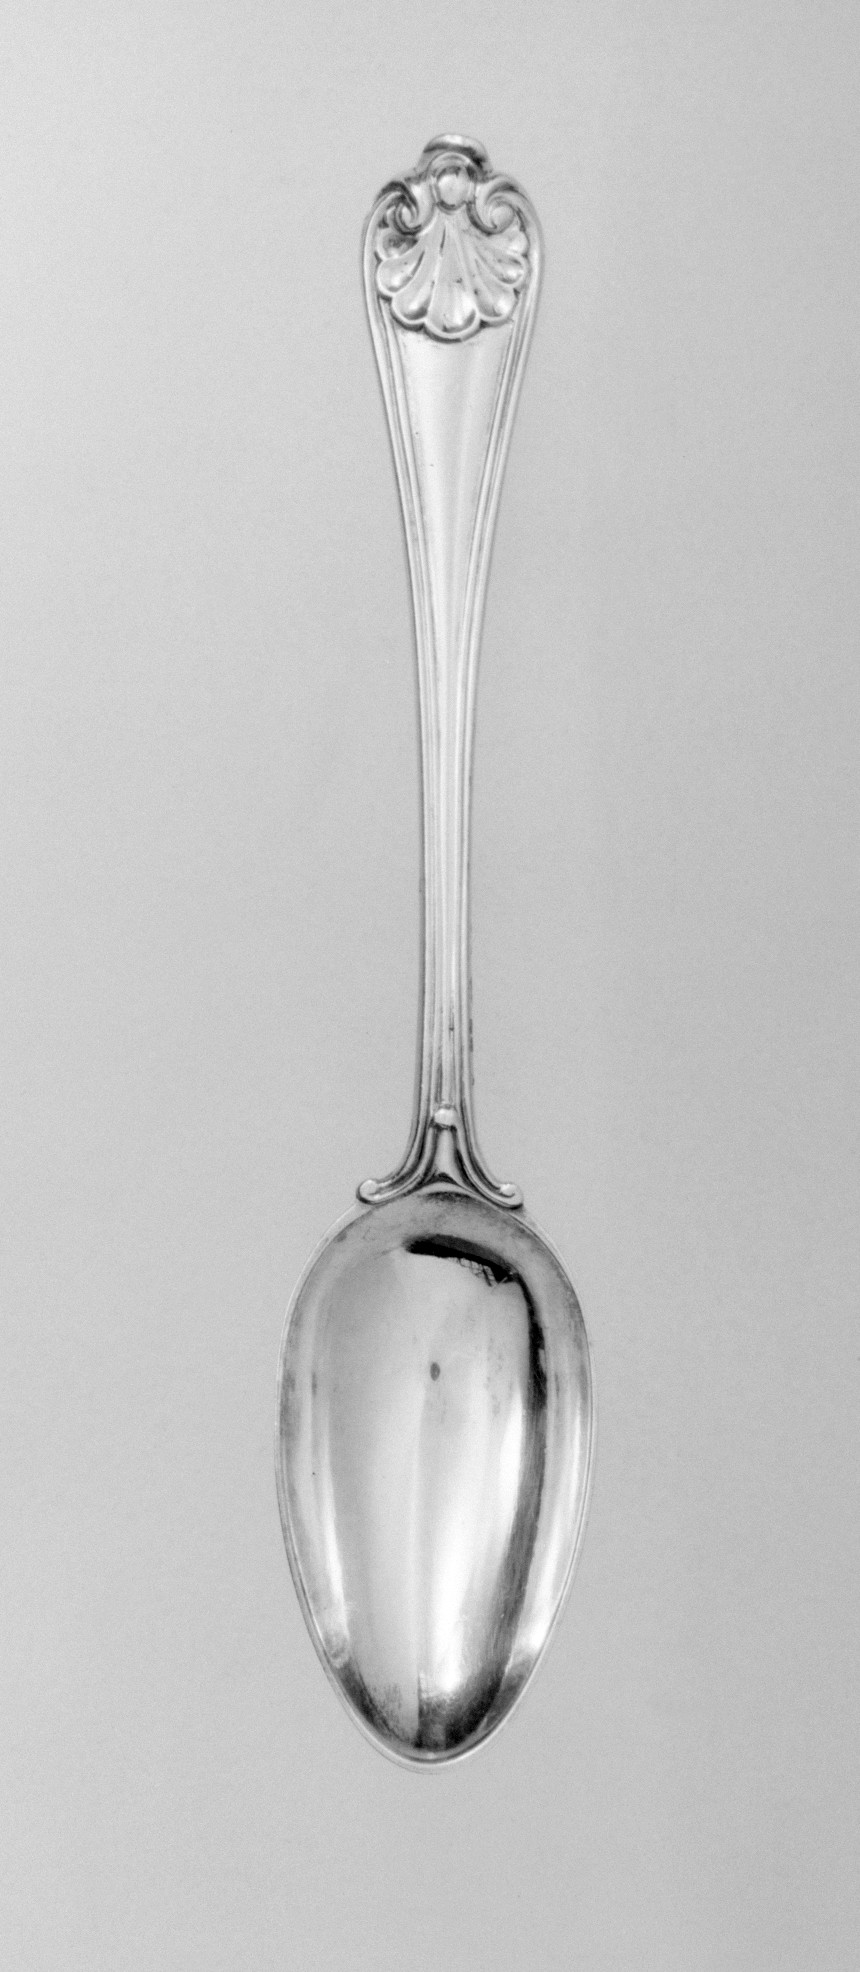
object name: spoon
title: Twelve spoons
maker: paul de lamerie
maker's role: maker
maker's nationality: british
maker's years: 1688-1751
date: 1701-1750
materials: silver gilt